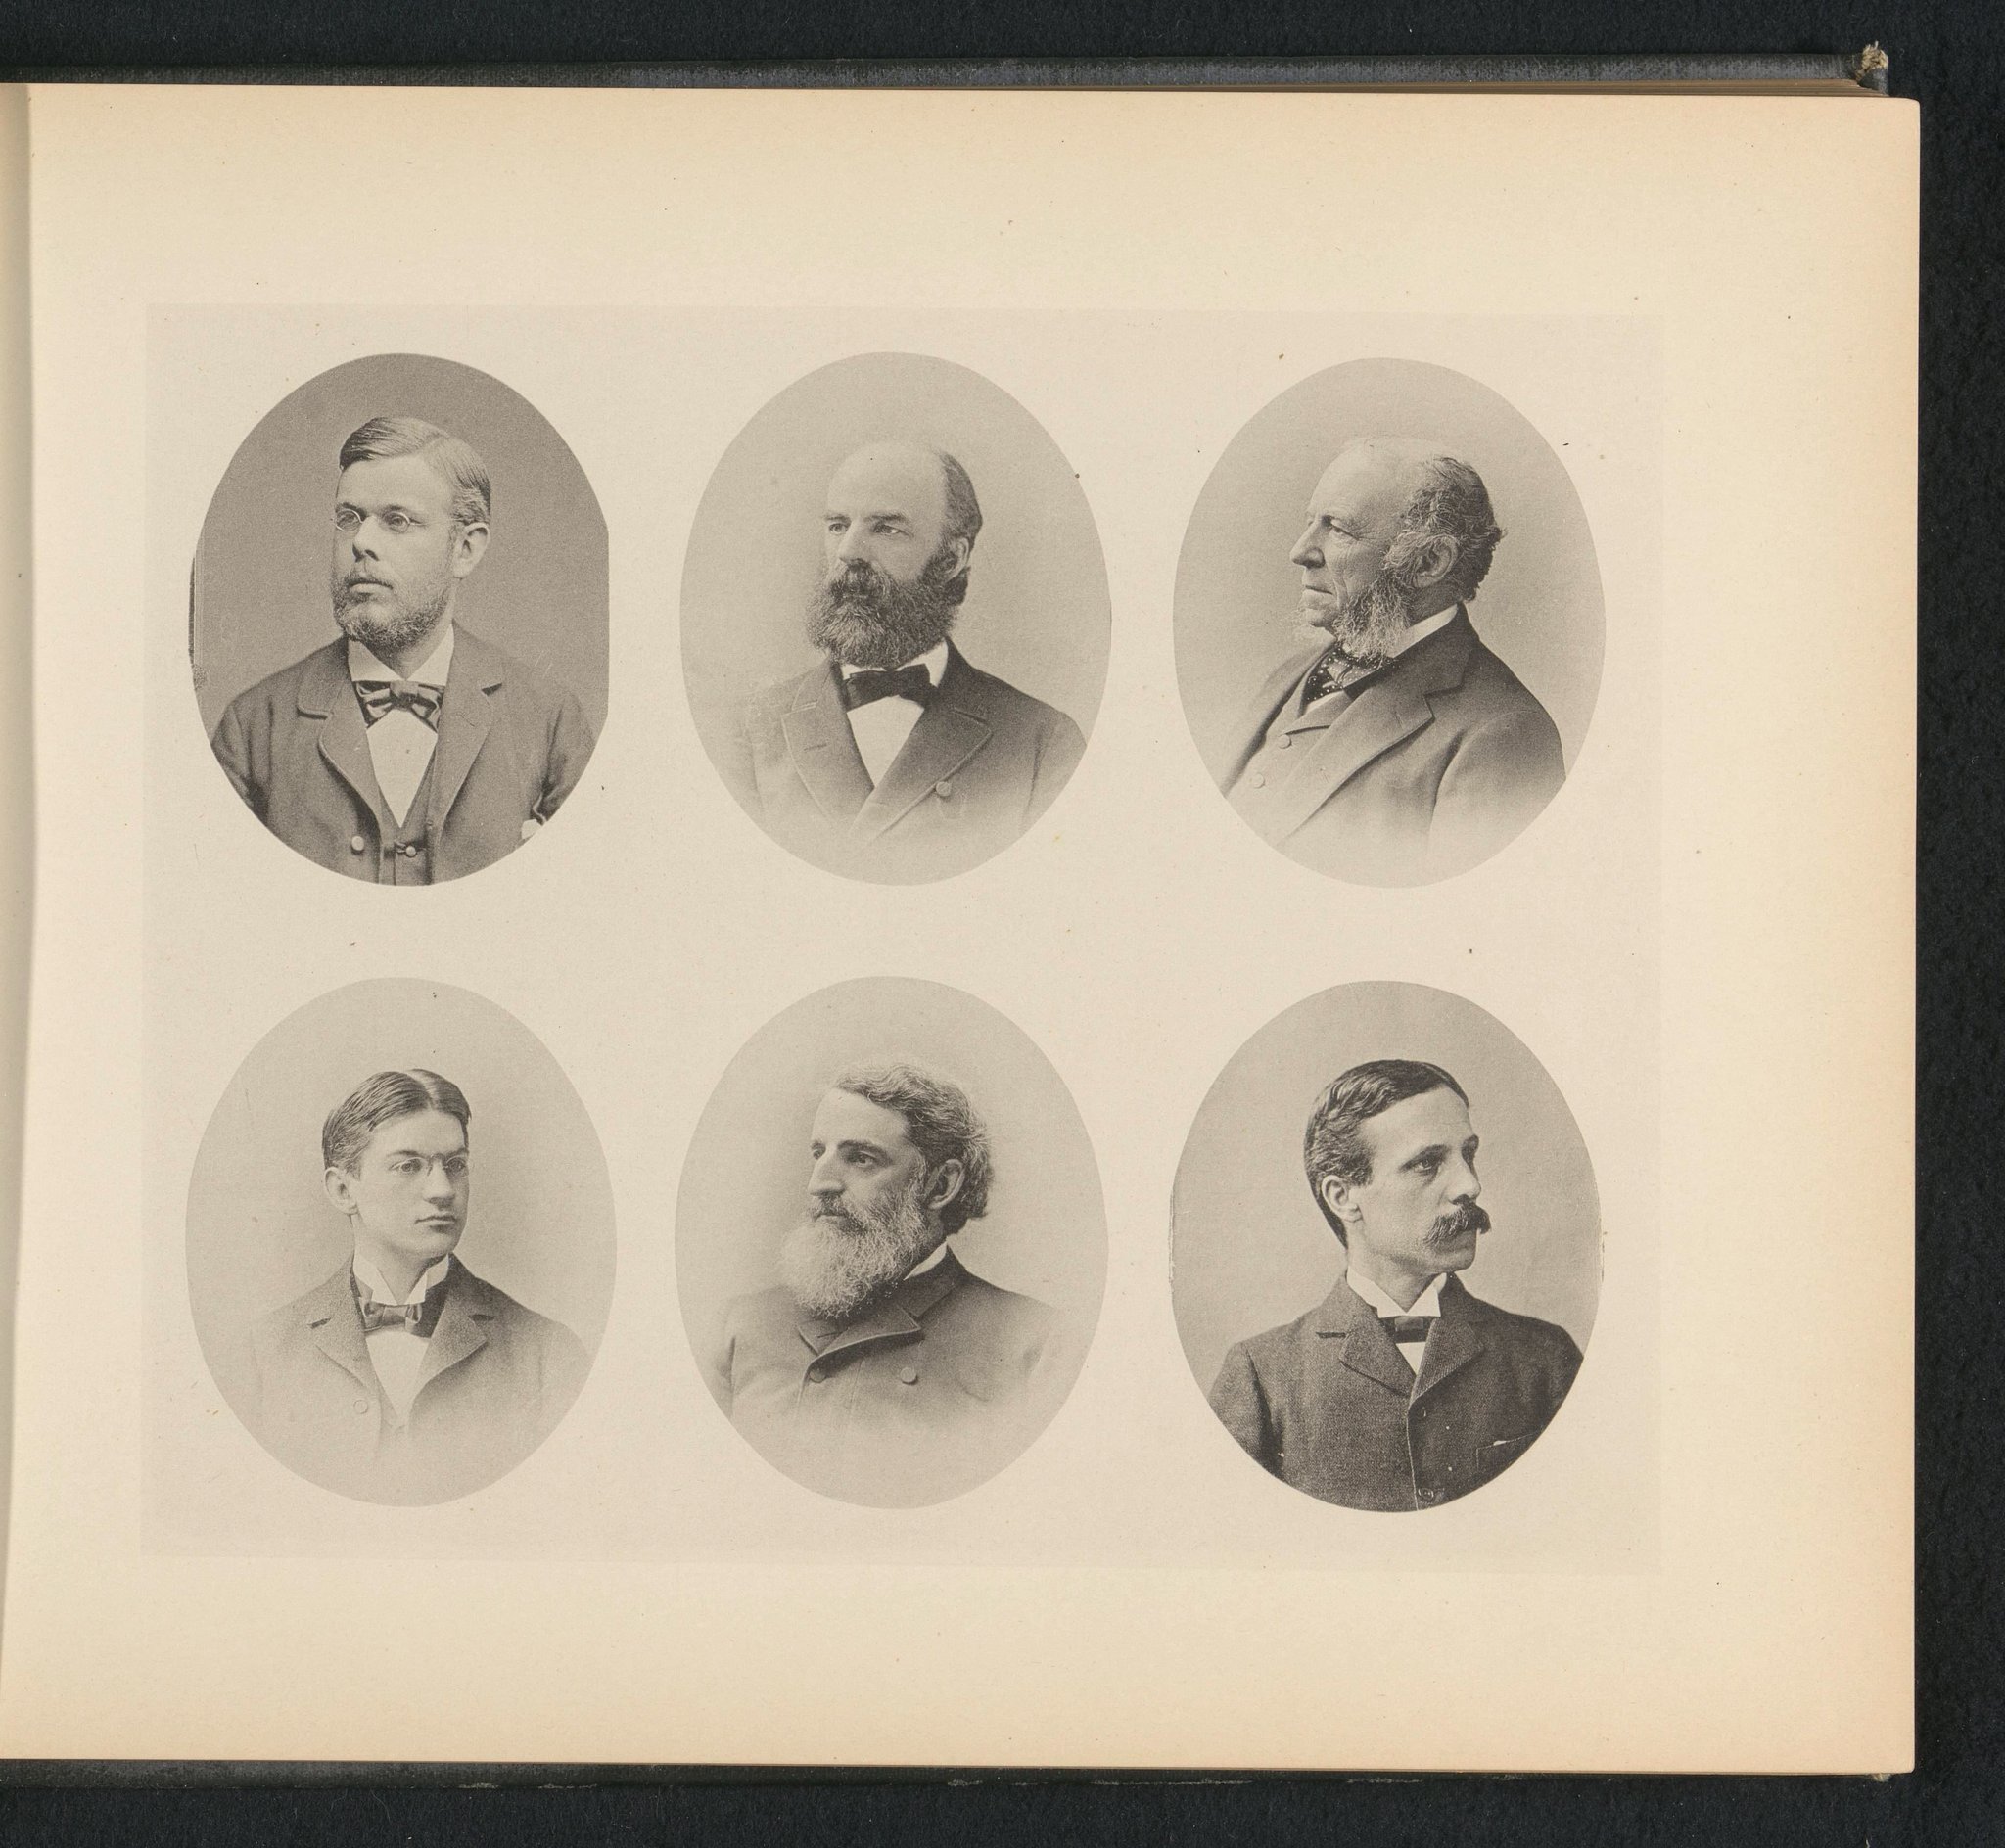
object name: page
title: Zes portretten van docenten aan Yale University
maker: Anonymous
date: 1895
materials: paper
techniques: photograph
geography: new york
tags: professor